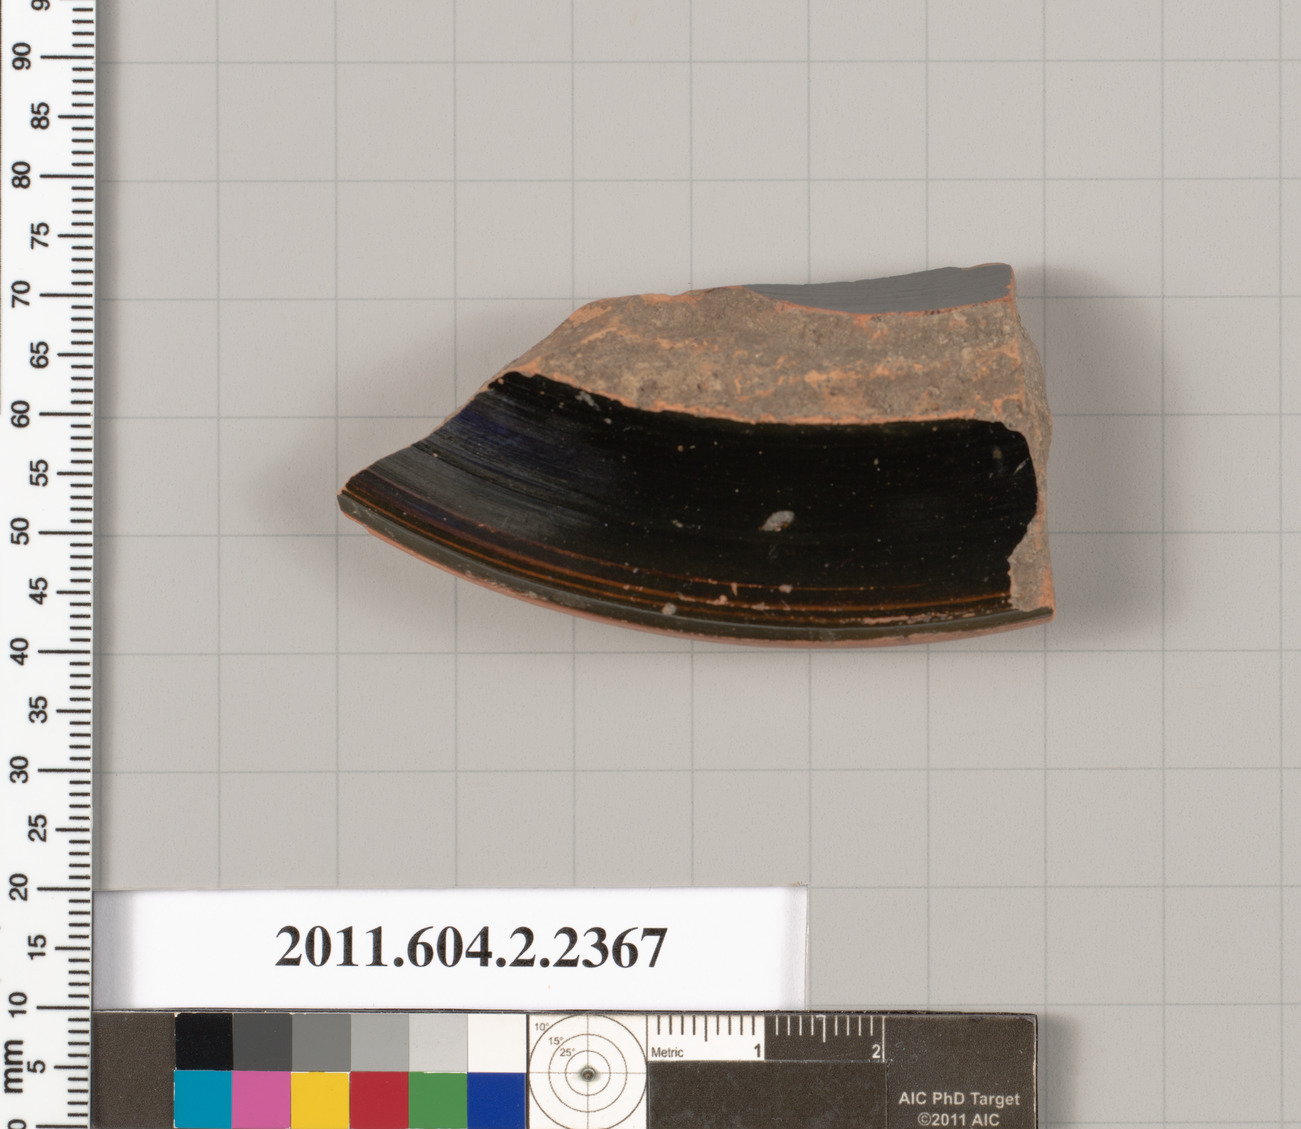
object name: pelike fragment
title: Terracotta fragment of a pelike (jar)?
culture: greek, attic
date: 490-470 BCE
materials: terracotta